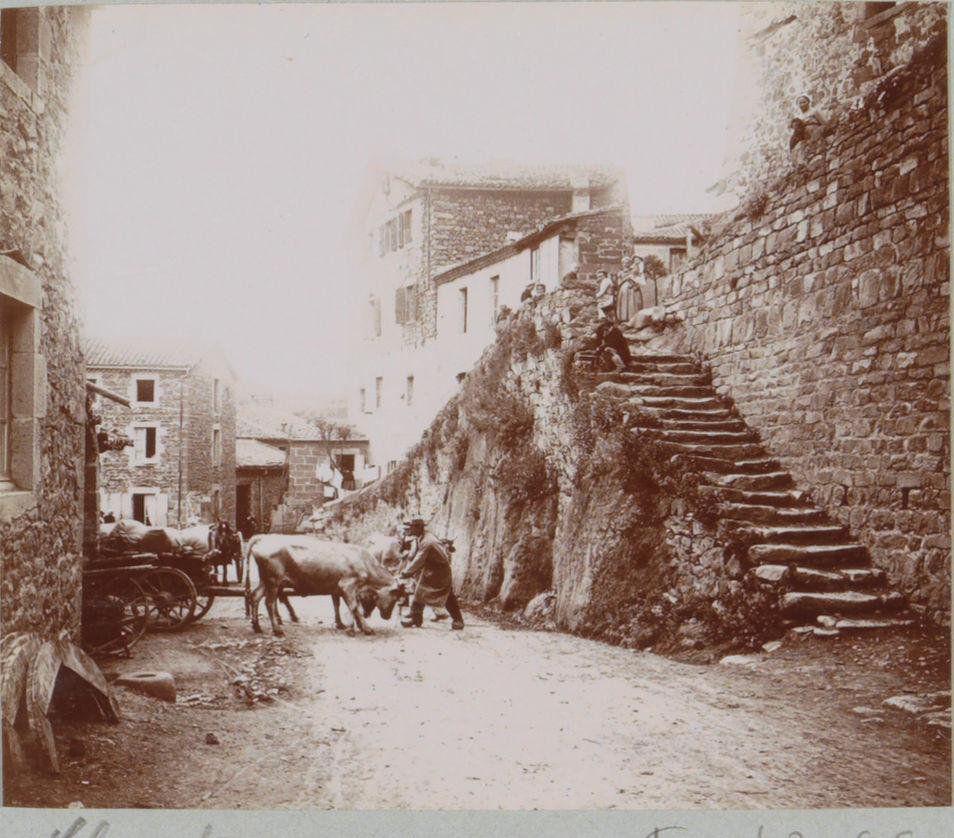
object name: photograph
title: Straatgezicht in Chanteuges met ossenkar, trap en kinderen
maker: delizy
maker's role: manufacturer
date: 1902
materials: paper, photographic support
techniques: gelatin silver print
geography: chanteuges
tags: animal traction, animal-drawn vehicle (carriage etc.), village street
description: Onderdeel van Fotoalbum van een Franse amateurfotograaf met opnames van uitstapjes in Frankrijk, Spanje, België, Luxemburg en Nederland, de eerste automobielen en autoraces.